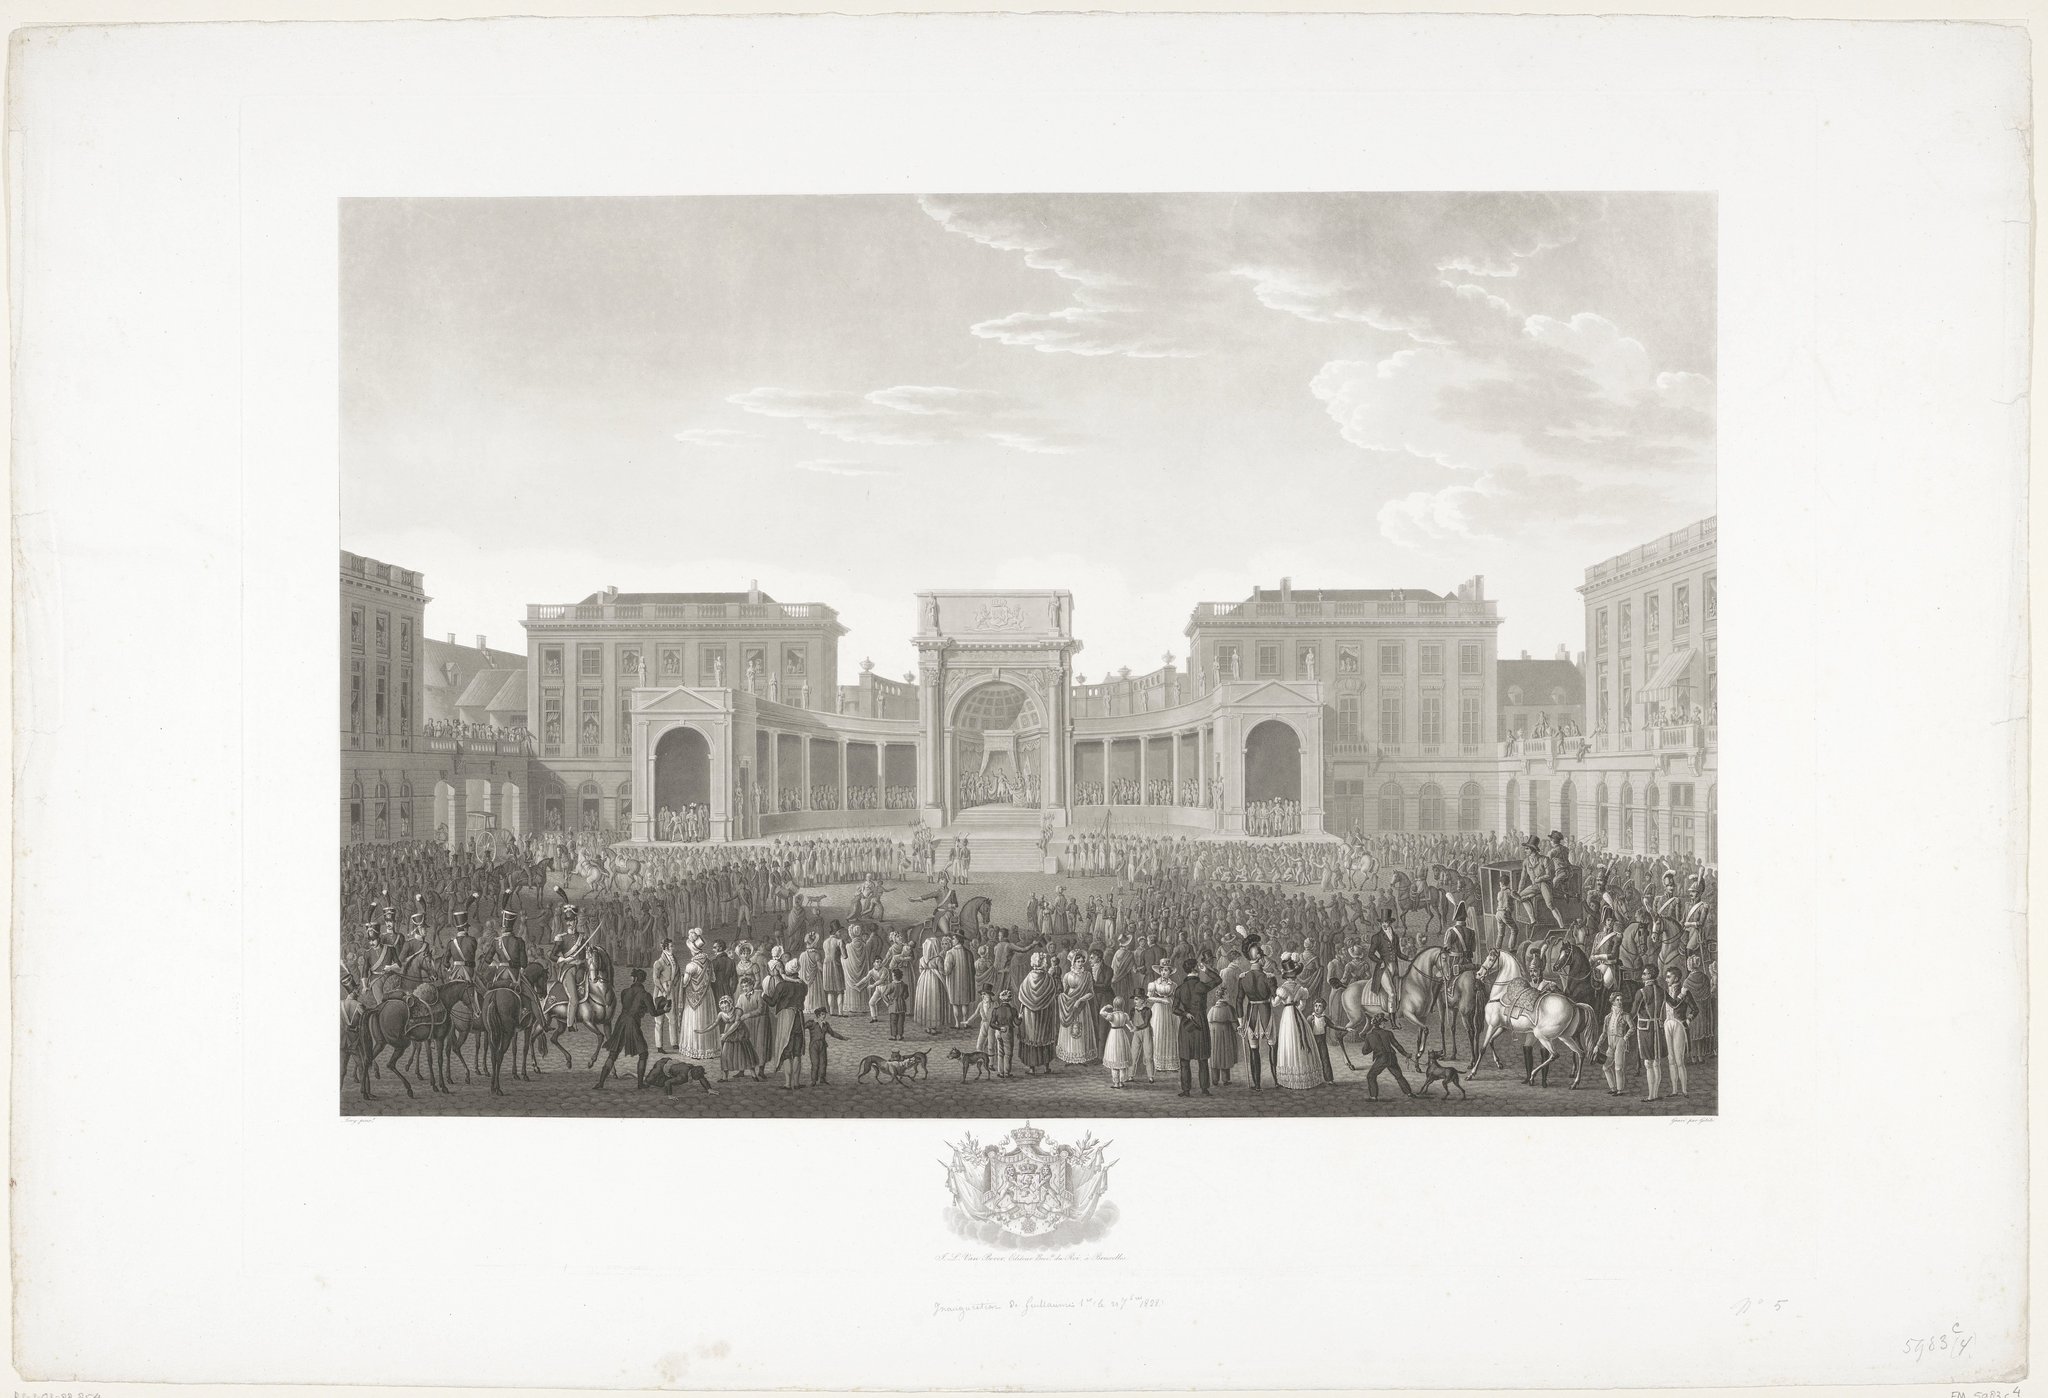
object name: history print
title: Twaalf platen van de aankomst en inhuldiging van Willem I in Brussel en de slagen bij Quatre-Bras en Waterloo in 1815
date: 1825-1826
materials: paper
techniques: aquatint, etching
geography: brussels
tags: berlin, william i of the netherlands, new ruler taking the oath, brussels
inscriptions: workshop stamp: ‘JLVB’, collector's mark: Lugt 12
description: Inhuldiging van koning Willem I te Brussel op 21 september 1815. Staande op een platform in de open lucht legt de koning ten overstaan van het publiek de eed af. Onderaan het wapen van koning Willem I. Onderdeel van een serie platen van de aankomst en inhuldiging van Willem I in Brussel.